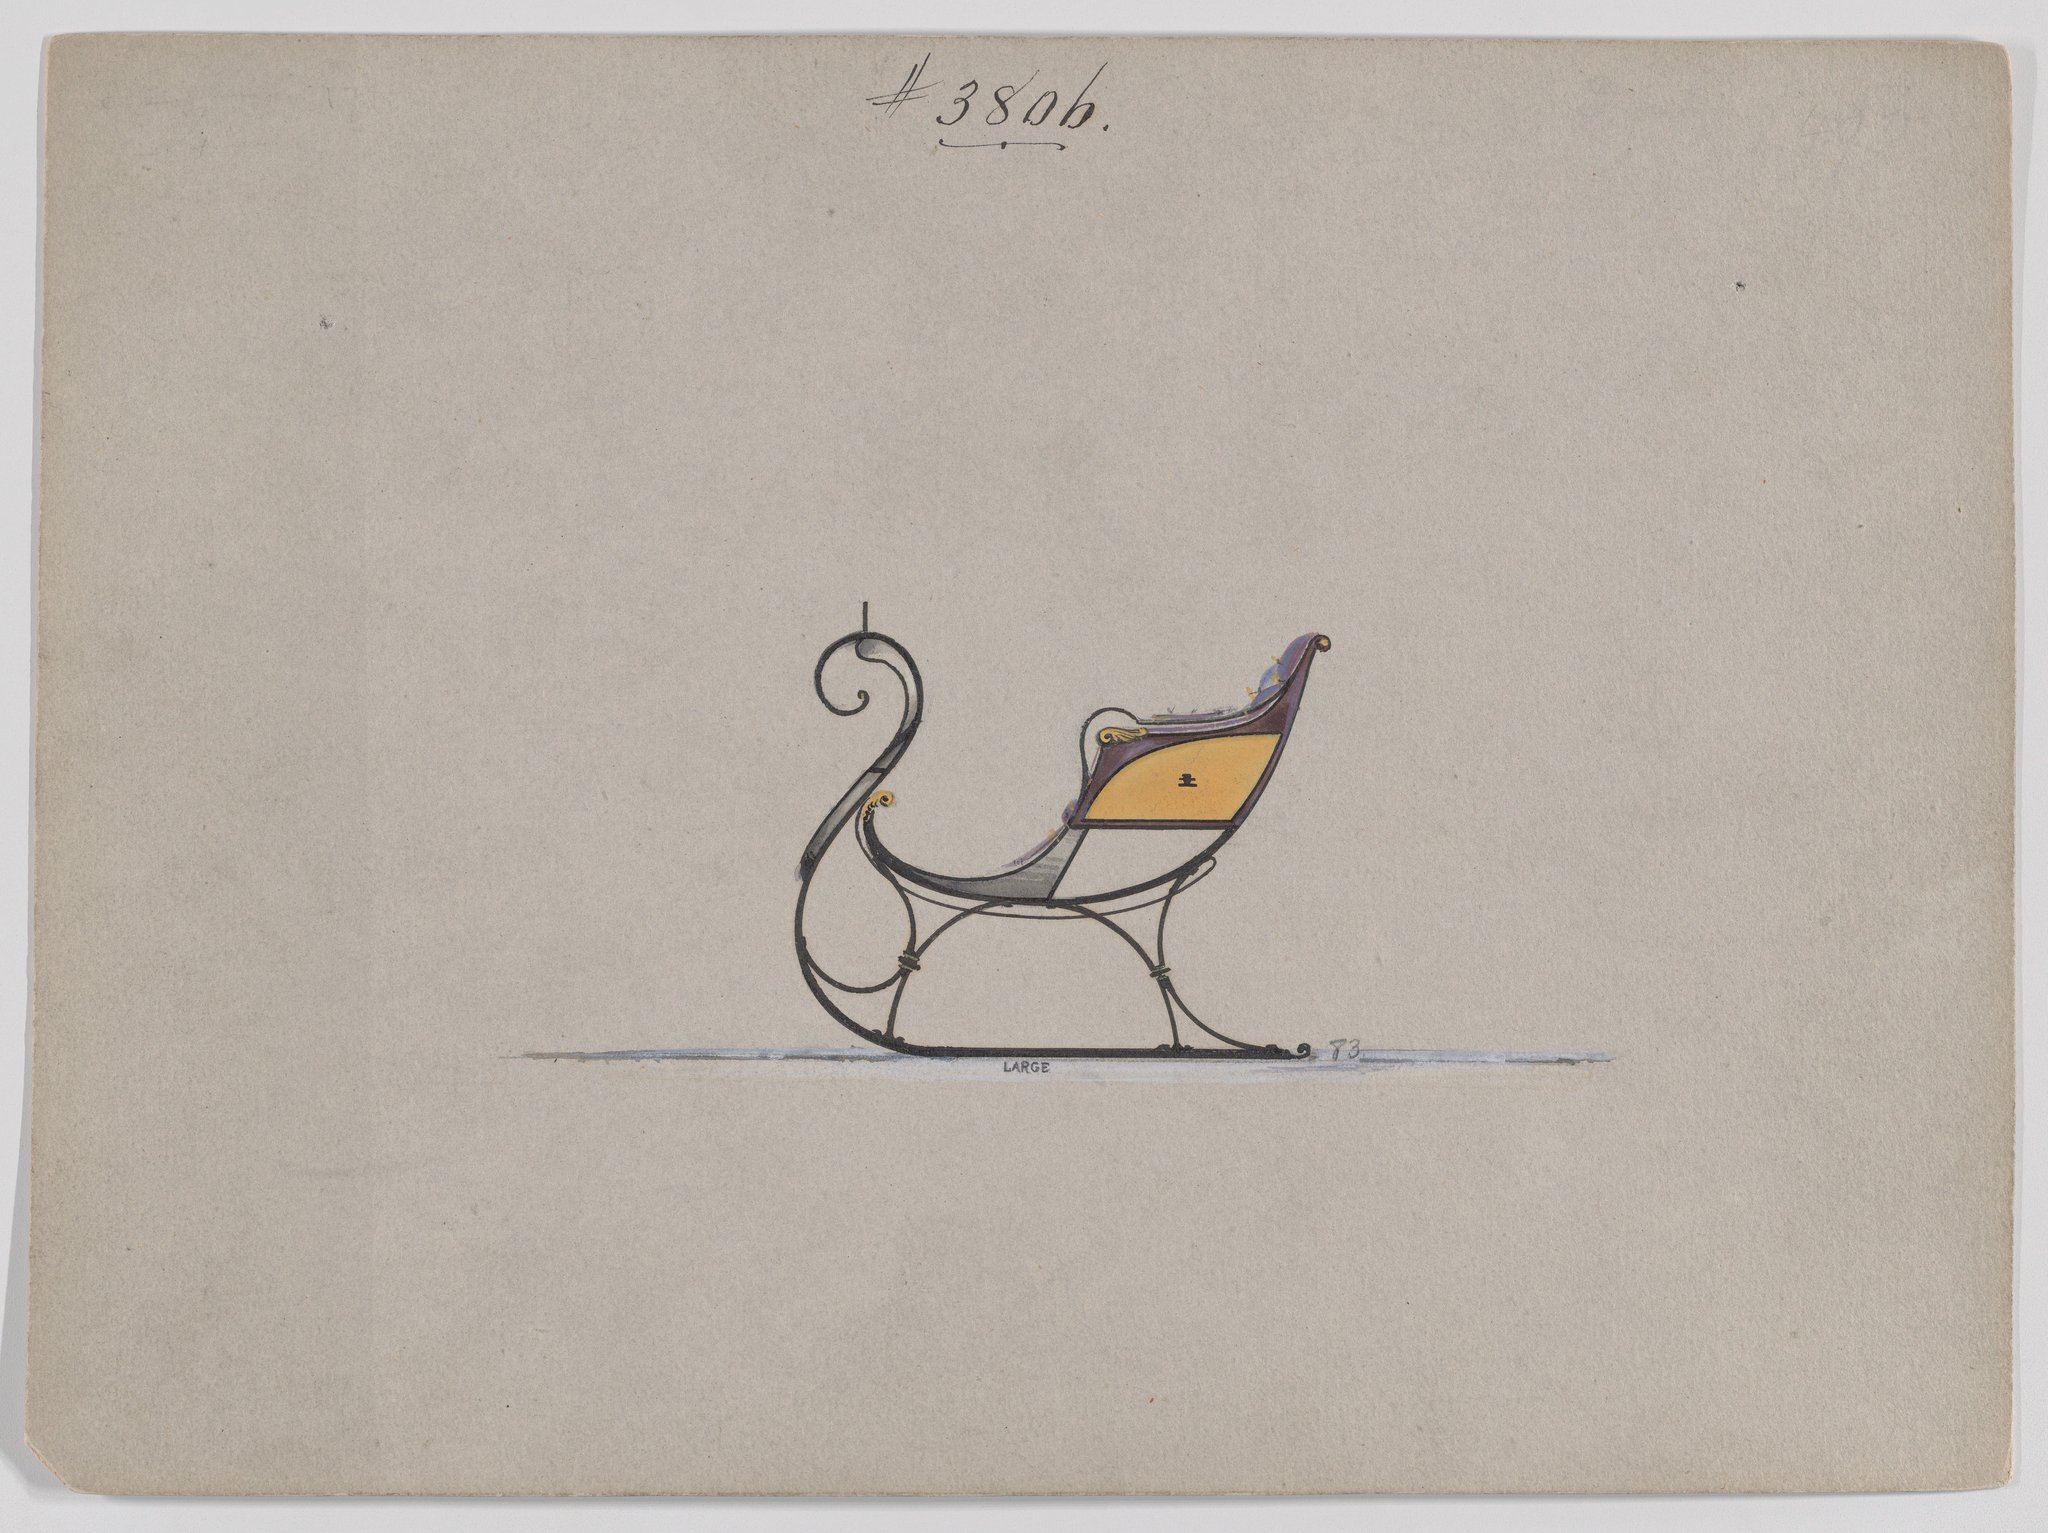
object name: drawing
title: Half Panel Sleigh #3806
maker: brewster & co.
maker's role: manufacturer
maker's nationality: american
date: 1883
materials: gouache, gum arabic, watercolor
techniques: pen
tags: sleighs